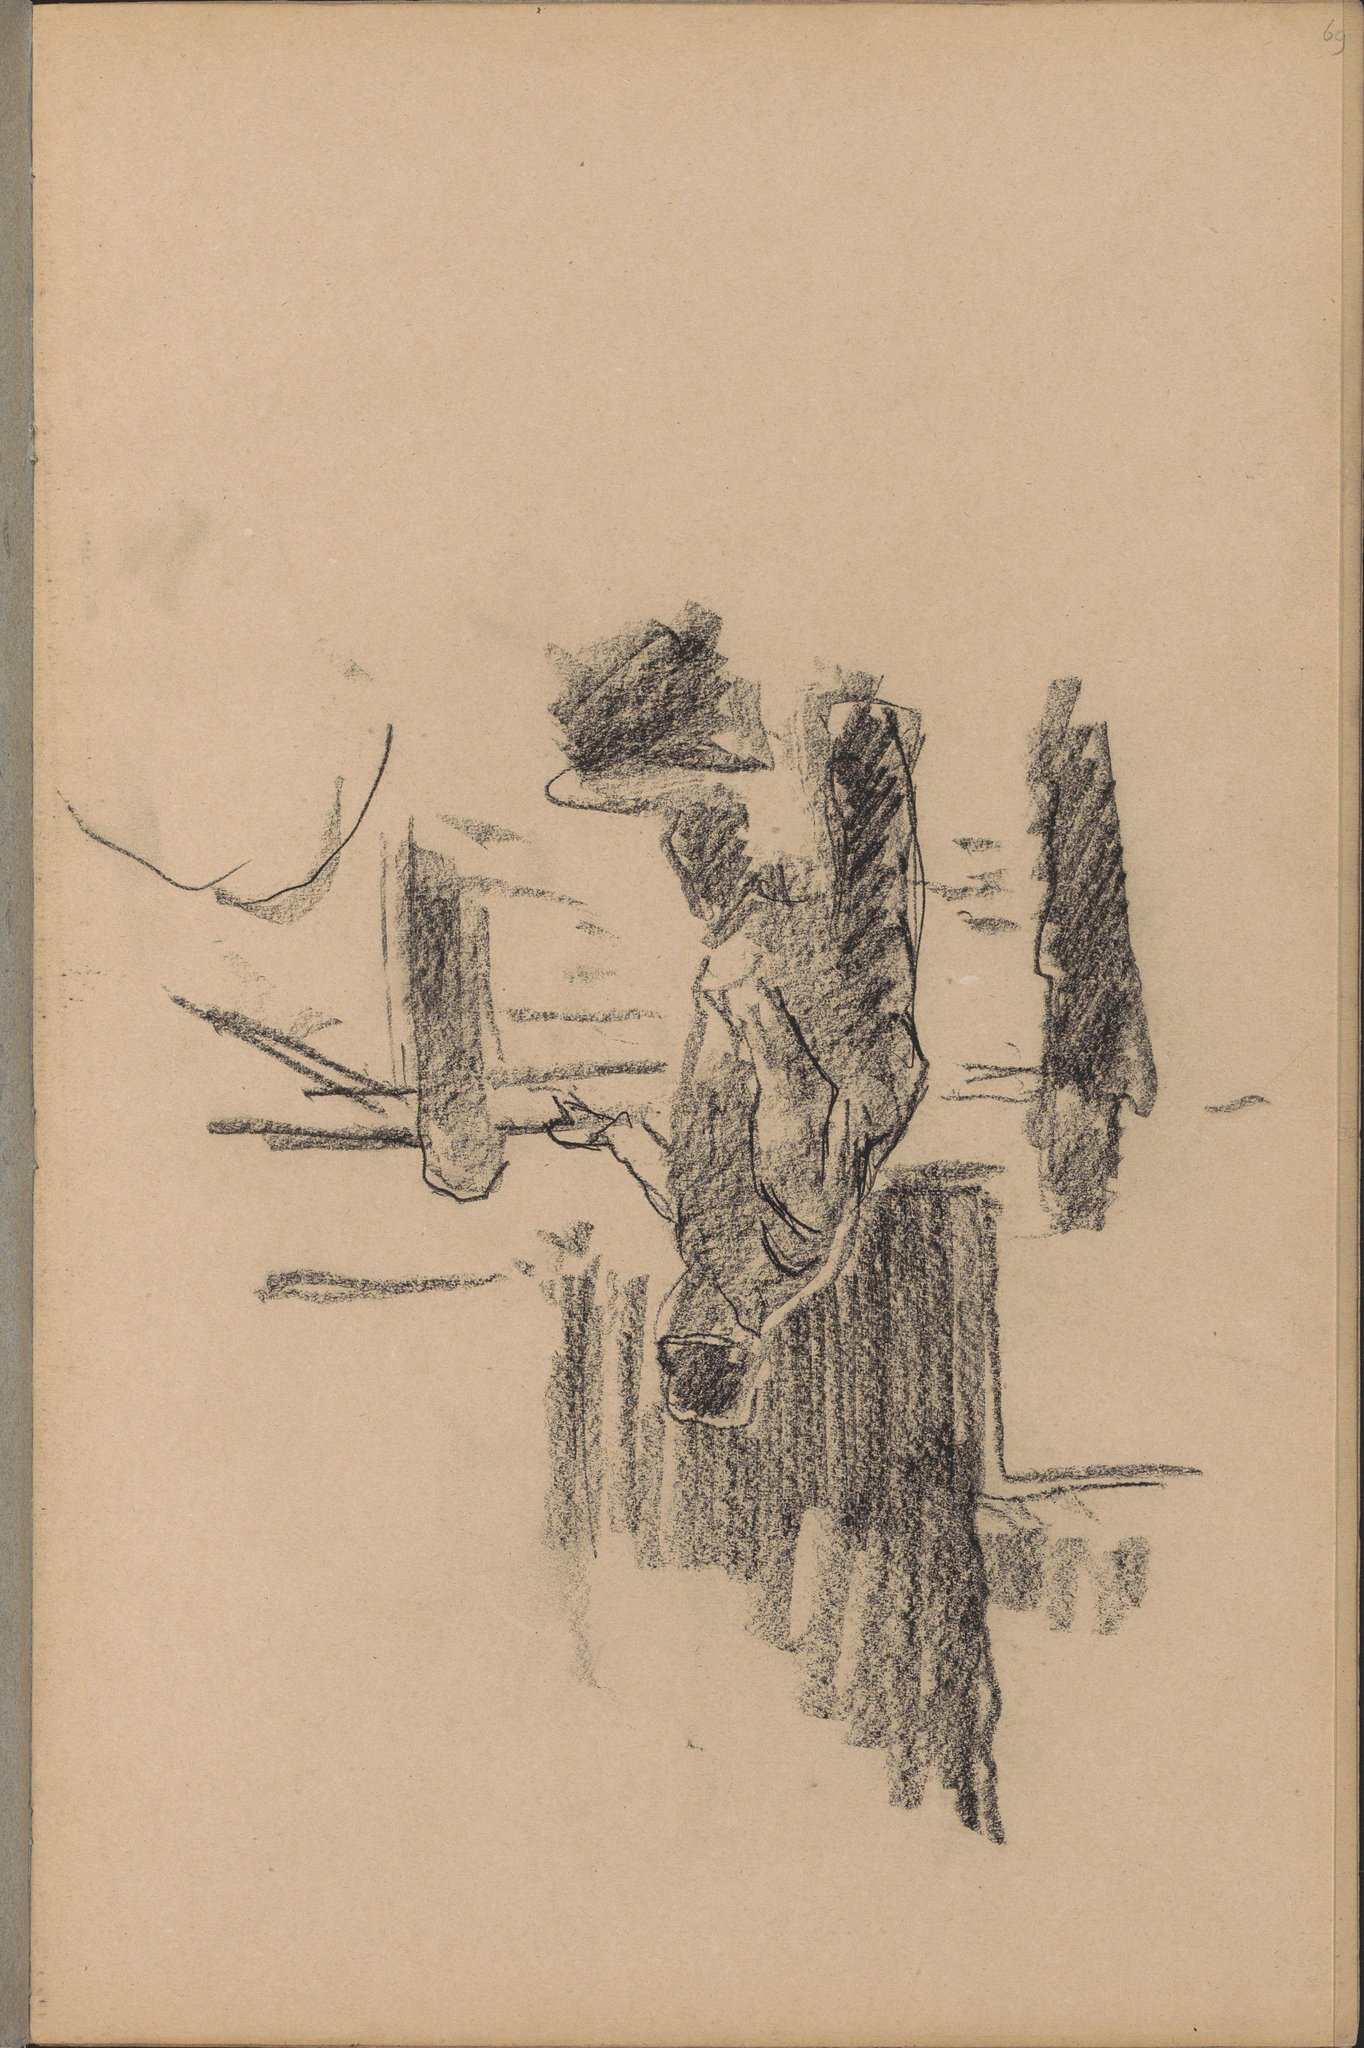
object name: sketchbook leaf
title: Man voor een hek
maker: willem witsen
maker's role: draughtsman, painter, print maker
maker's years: 1860-1923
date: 1884-1887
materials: chalk, paper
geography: ewijkshoeve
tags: fence, wall, paling, adult man (+ standing), civic architecture; edifices; dwellings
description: Pagina 69 uit een schetsboek met 44 bladen.